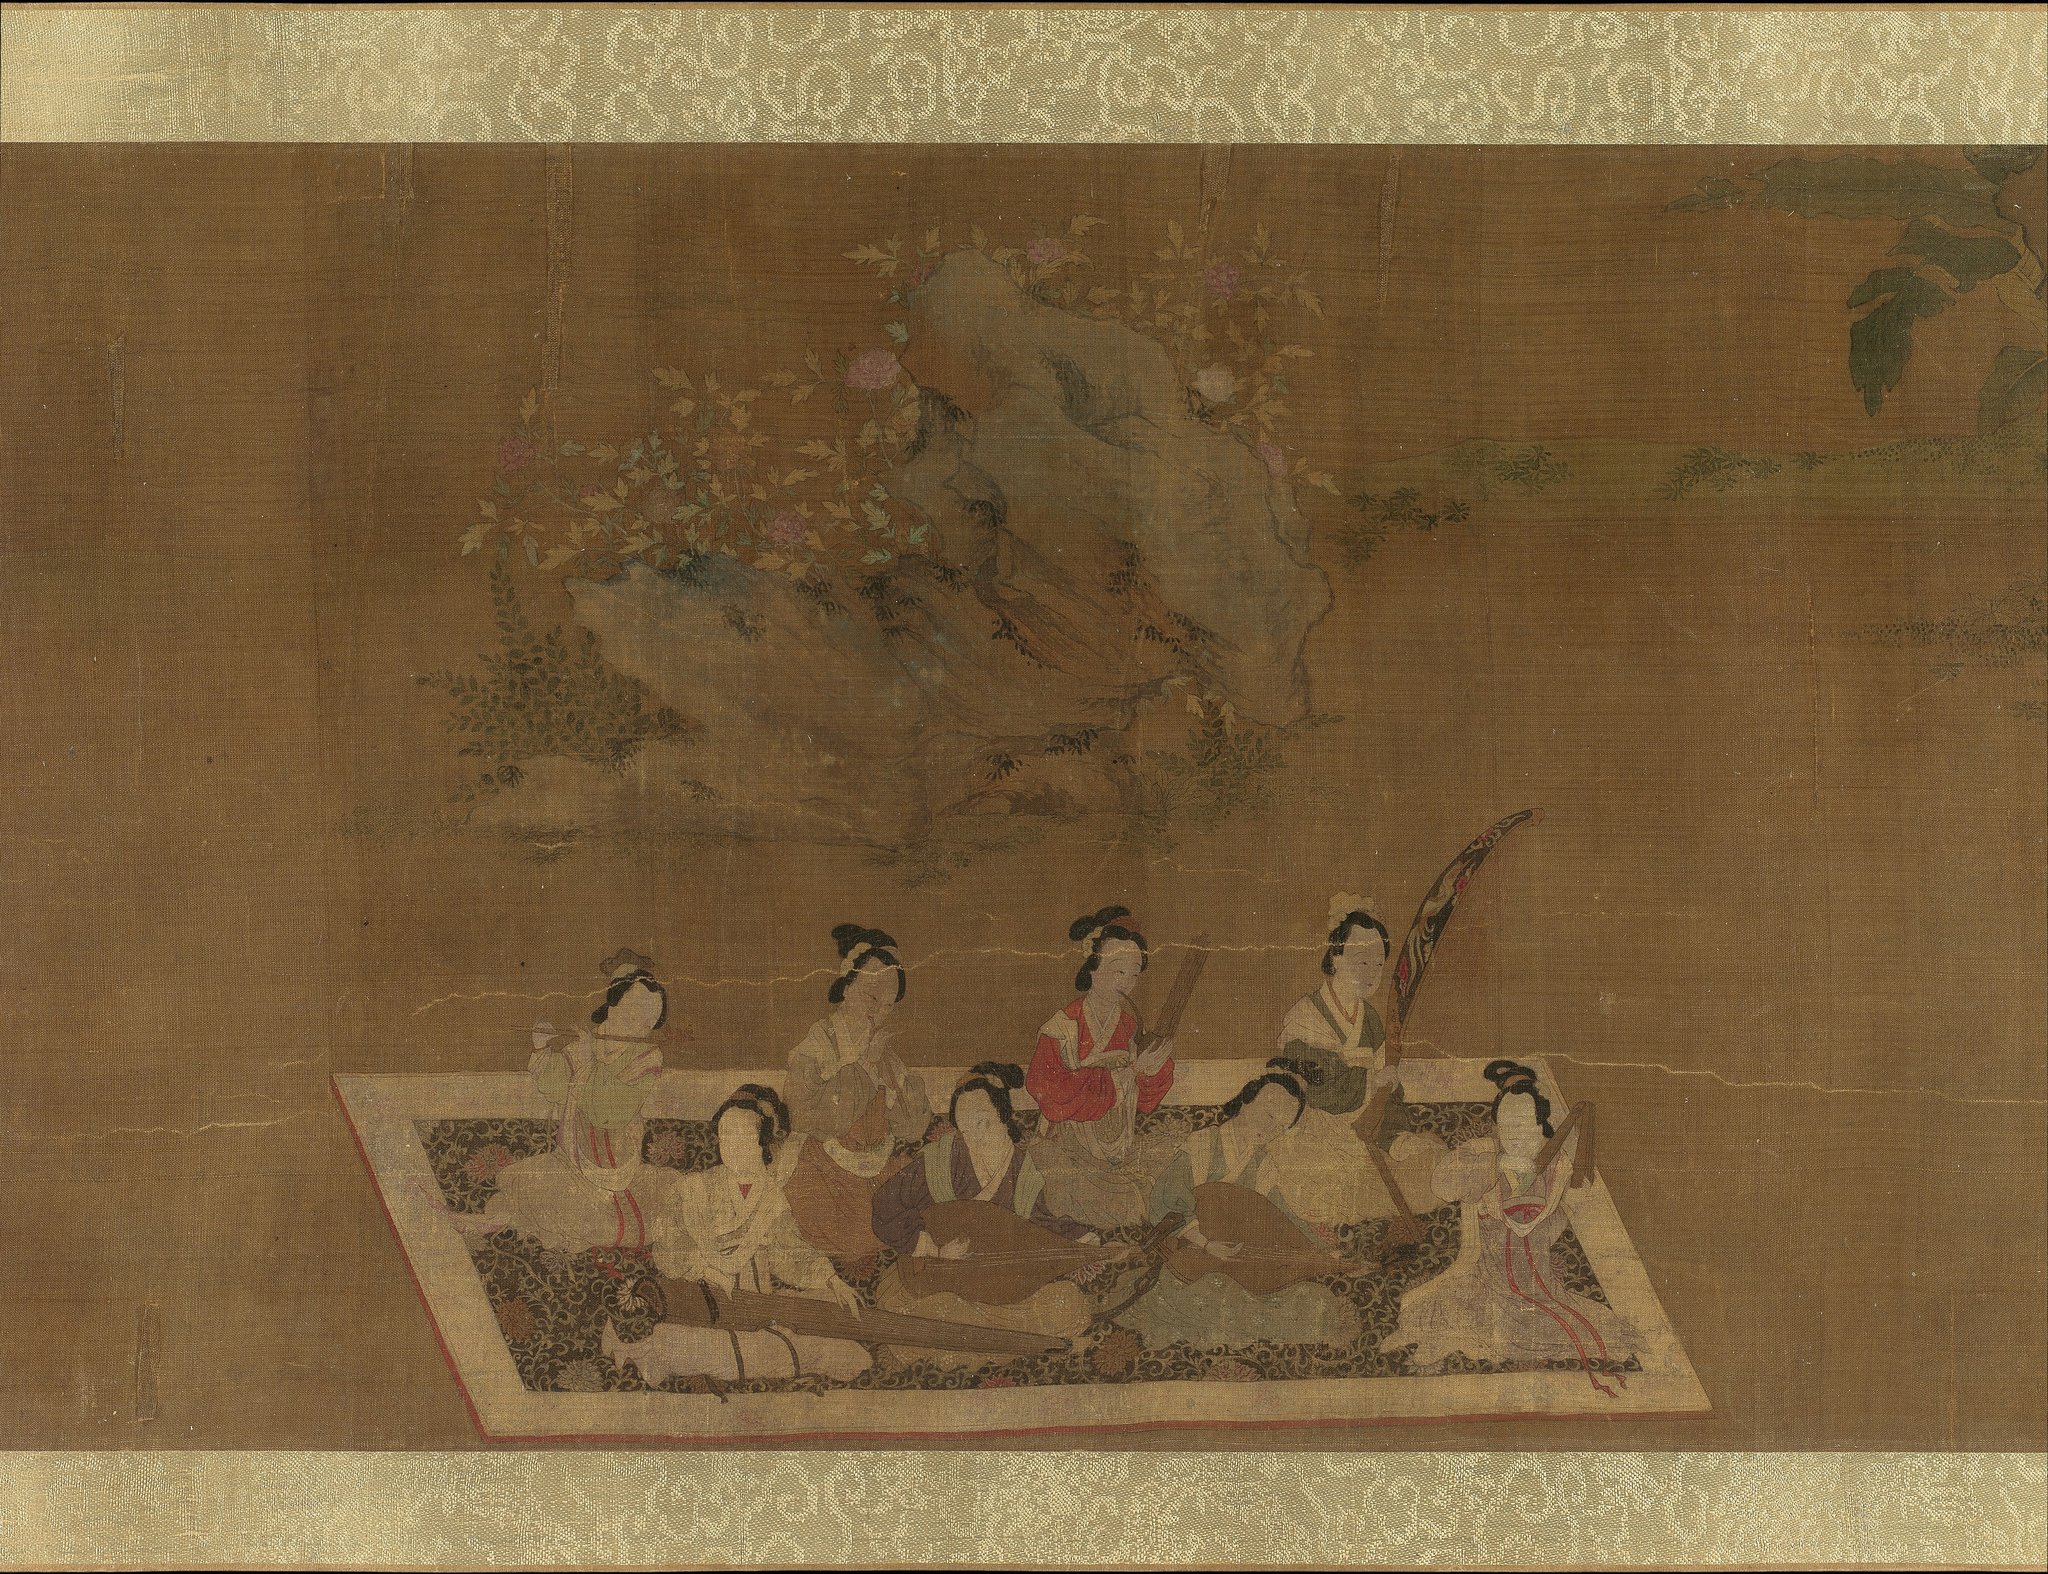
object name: handscroll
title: Lady Su Hui and Her Verse Puzzle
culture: chinese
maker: qiu ying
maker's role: artist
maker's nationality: chinese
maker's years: 1485-1562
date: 1501-1600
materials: ink, silk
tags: musical instruments,women